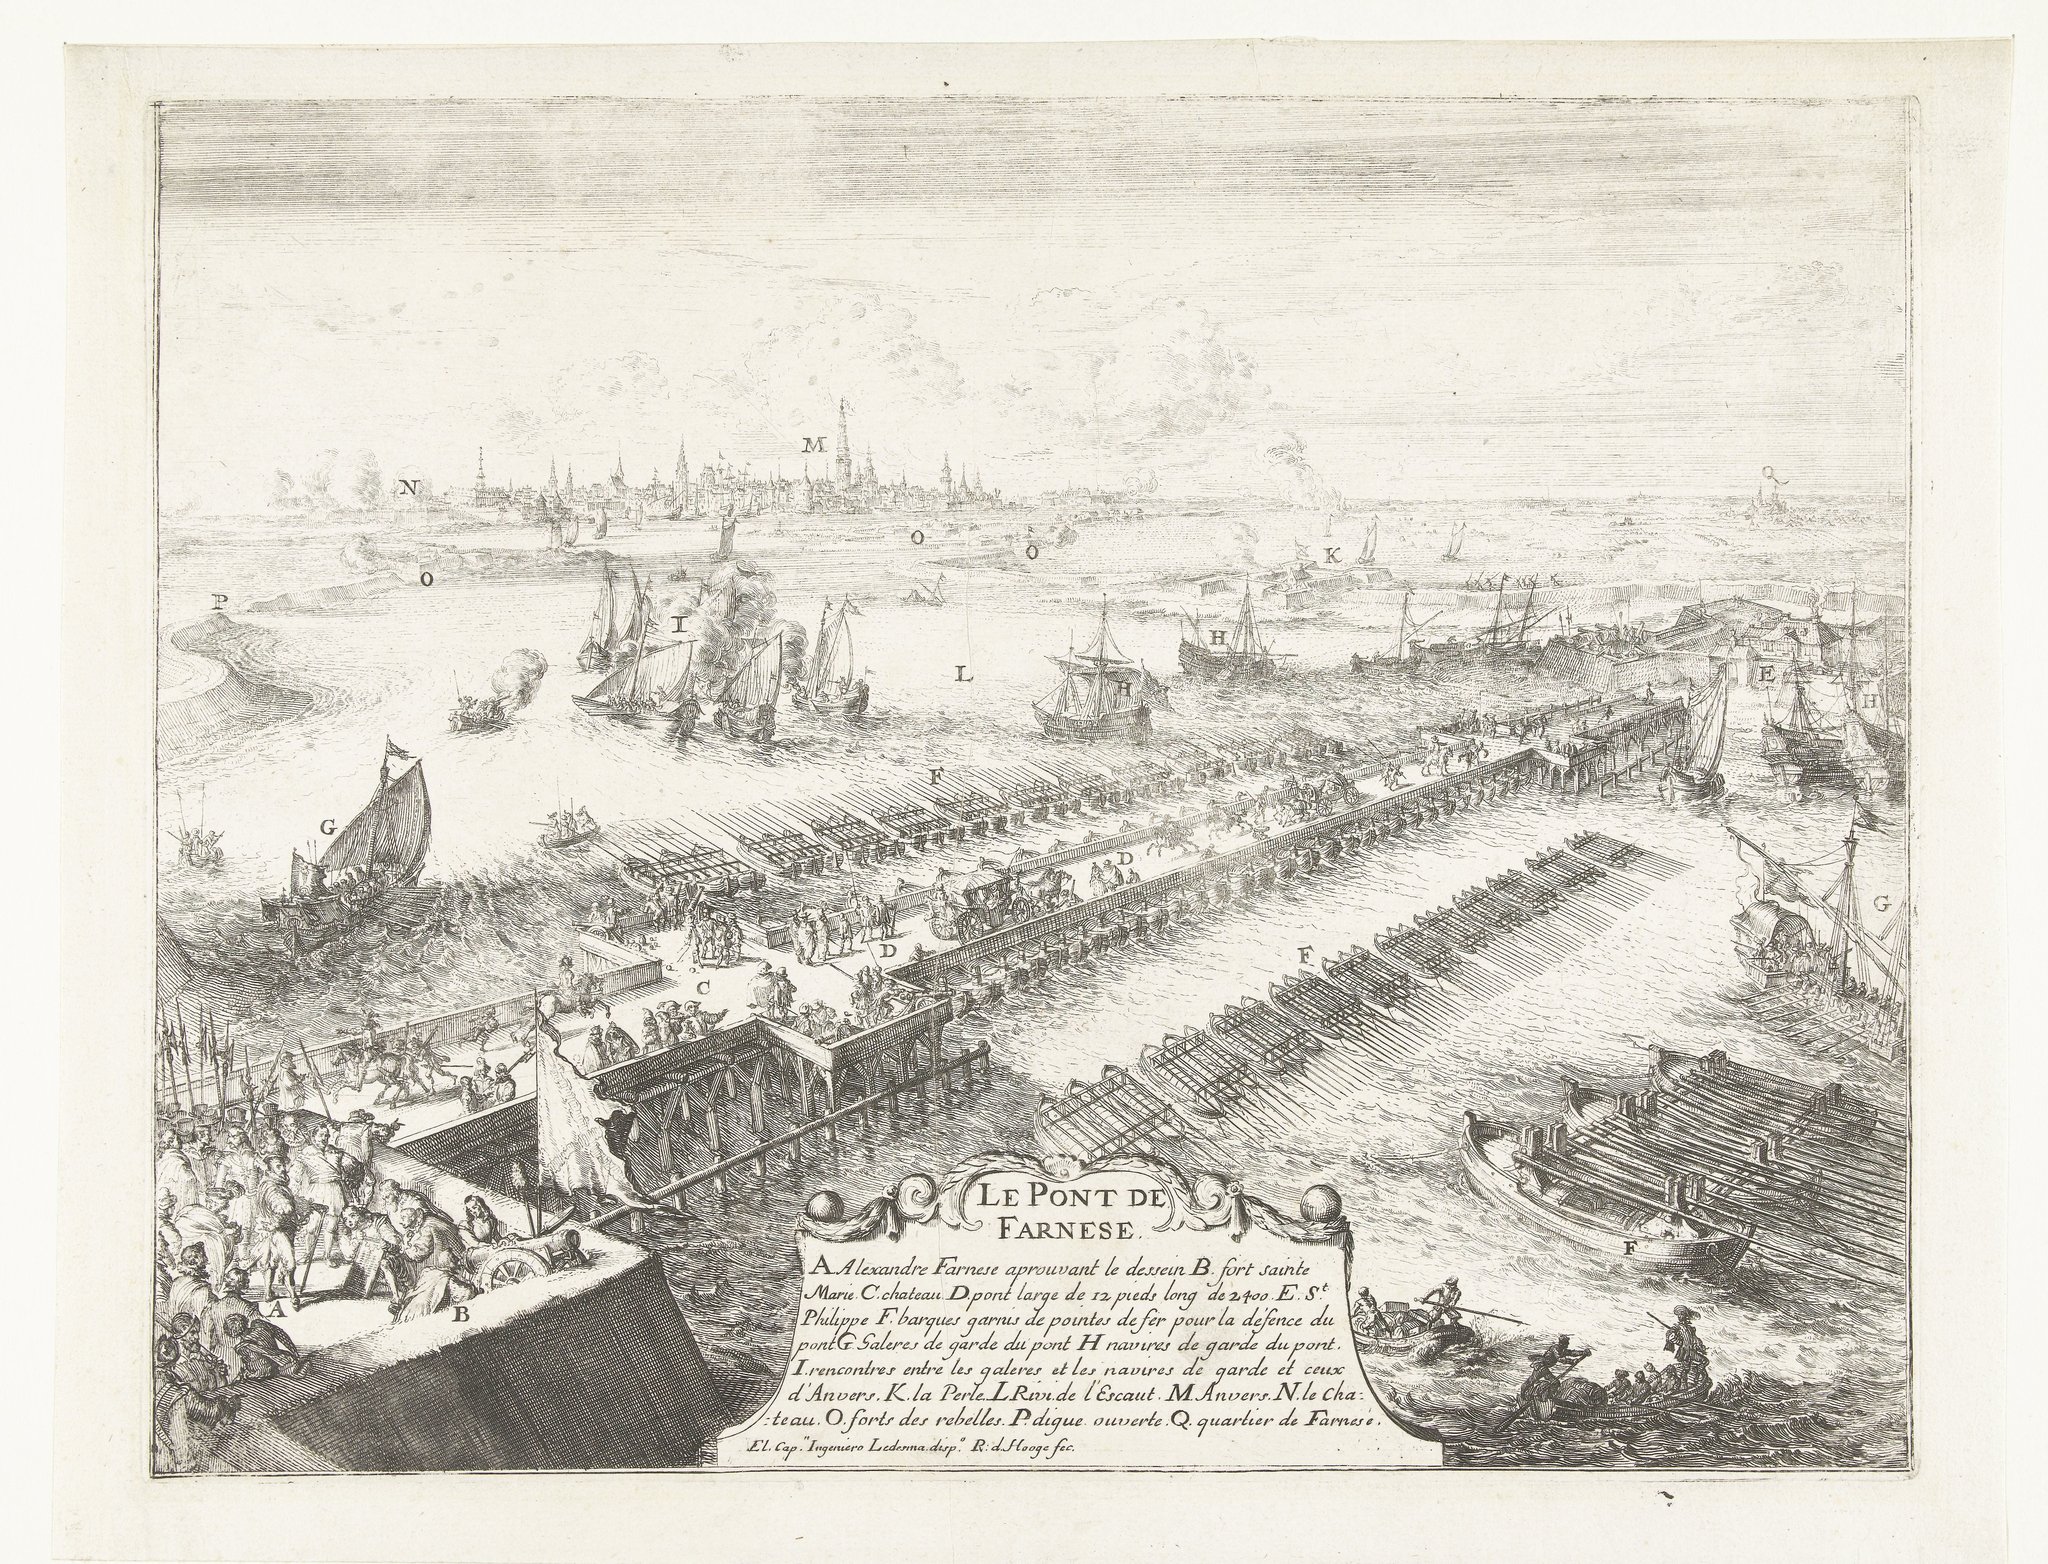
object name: print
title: Le pont de Farnese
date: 1670-1699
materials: paper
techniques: etching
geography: northern netherlands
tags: rome, alessandro farnese (landvoogd van de nederlanden en hertog van parma en piacenza), pontoon bridge, antwerp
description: De schipbrug aangelegd door de hertog van Parma over de Schelde, 1585. Linksvoor keurt Farnese het ontwerp voor de schipbrug goed. In de verte de stad Antwerpen. Rijtuigen en soldaten gaan over de voltooide brug. Middenonder een cartouche met de titel en de legenda A-Q in het Frans.